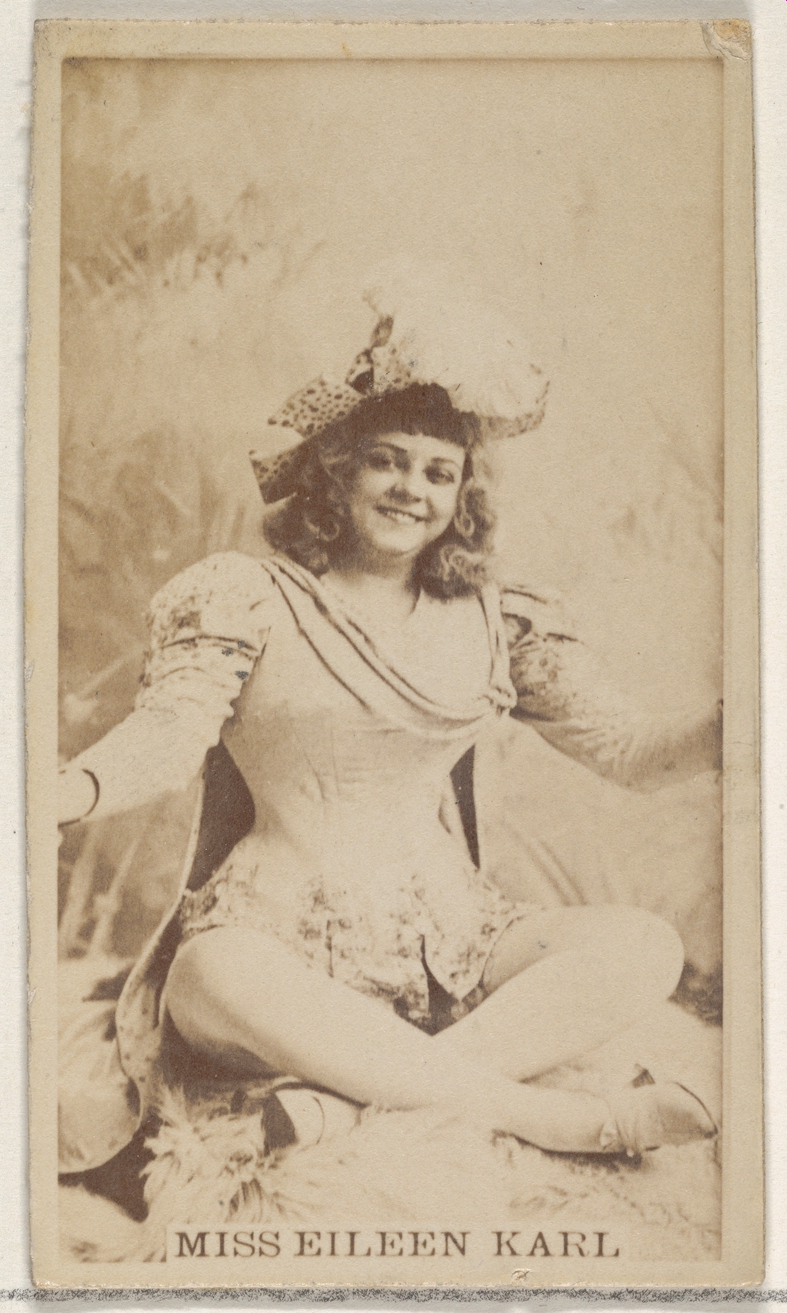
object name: photograph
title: Miss Eileen Karl, from the Actors and Actresses series (N45, Type 8) for Virginia Brights Cigarettes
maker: allen & ginter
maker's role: publisher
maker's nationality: american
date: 1888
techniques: albumen silver print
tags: portraits,women,actresses